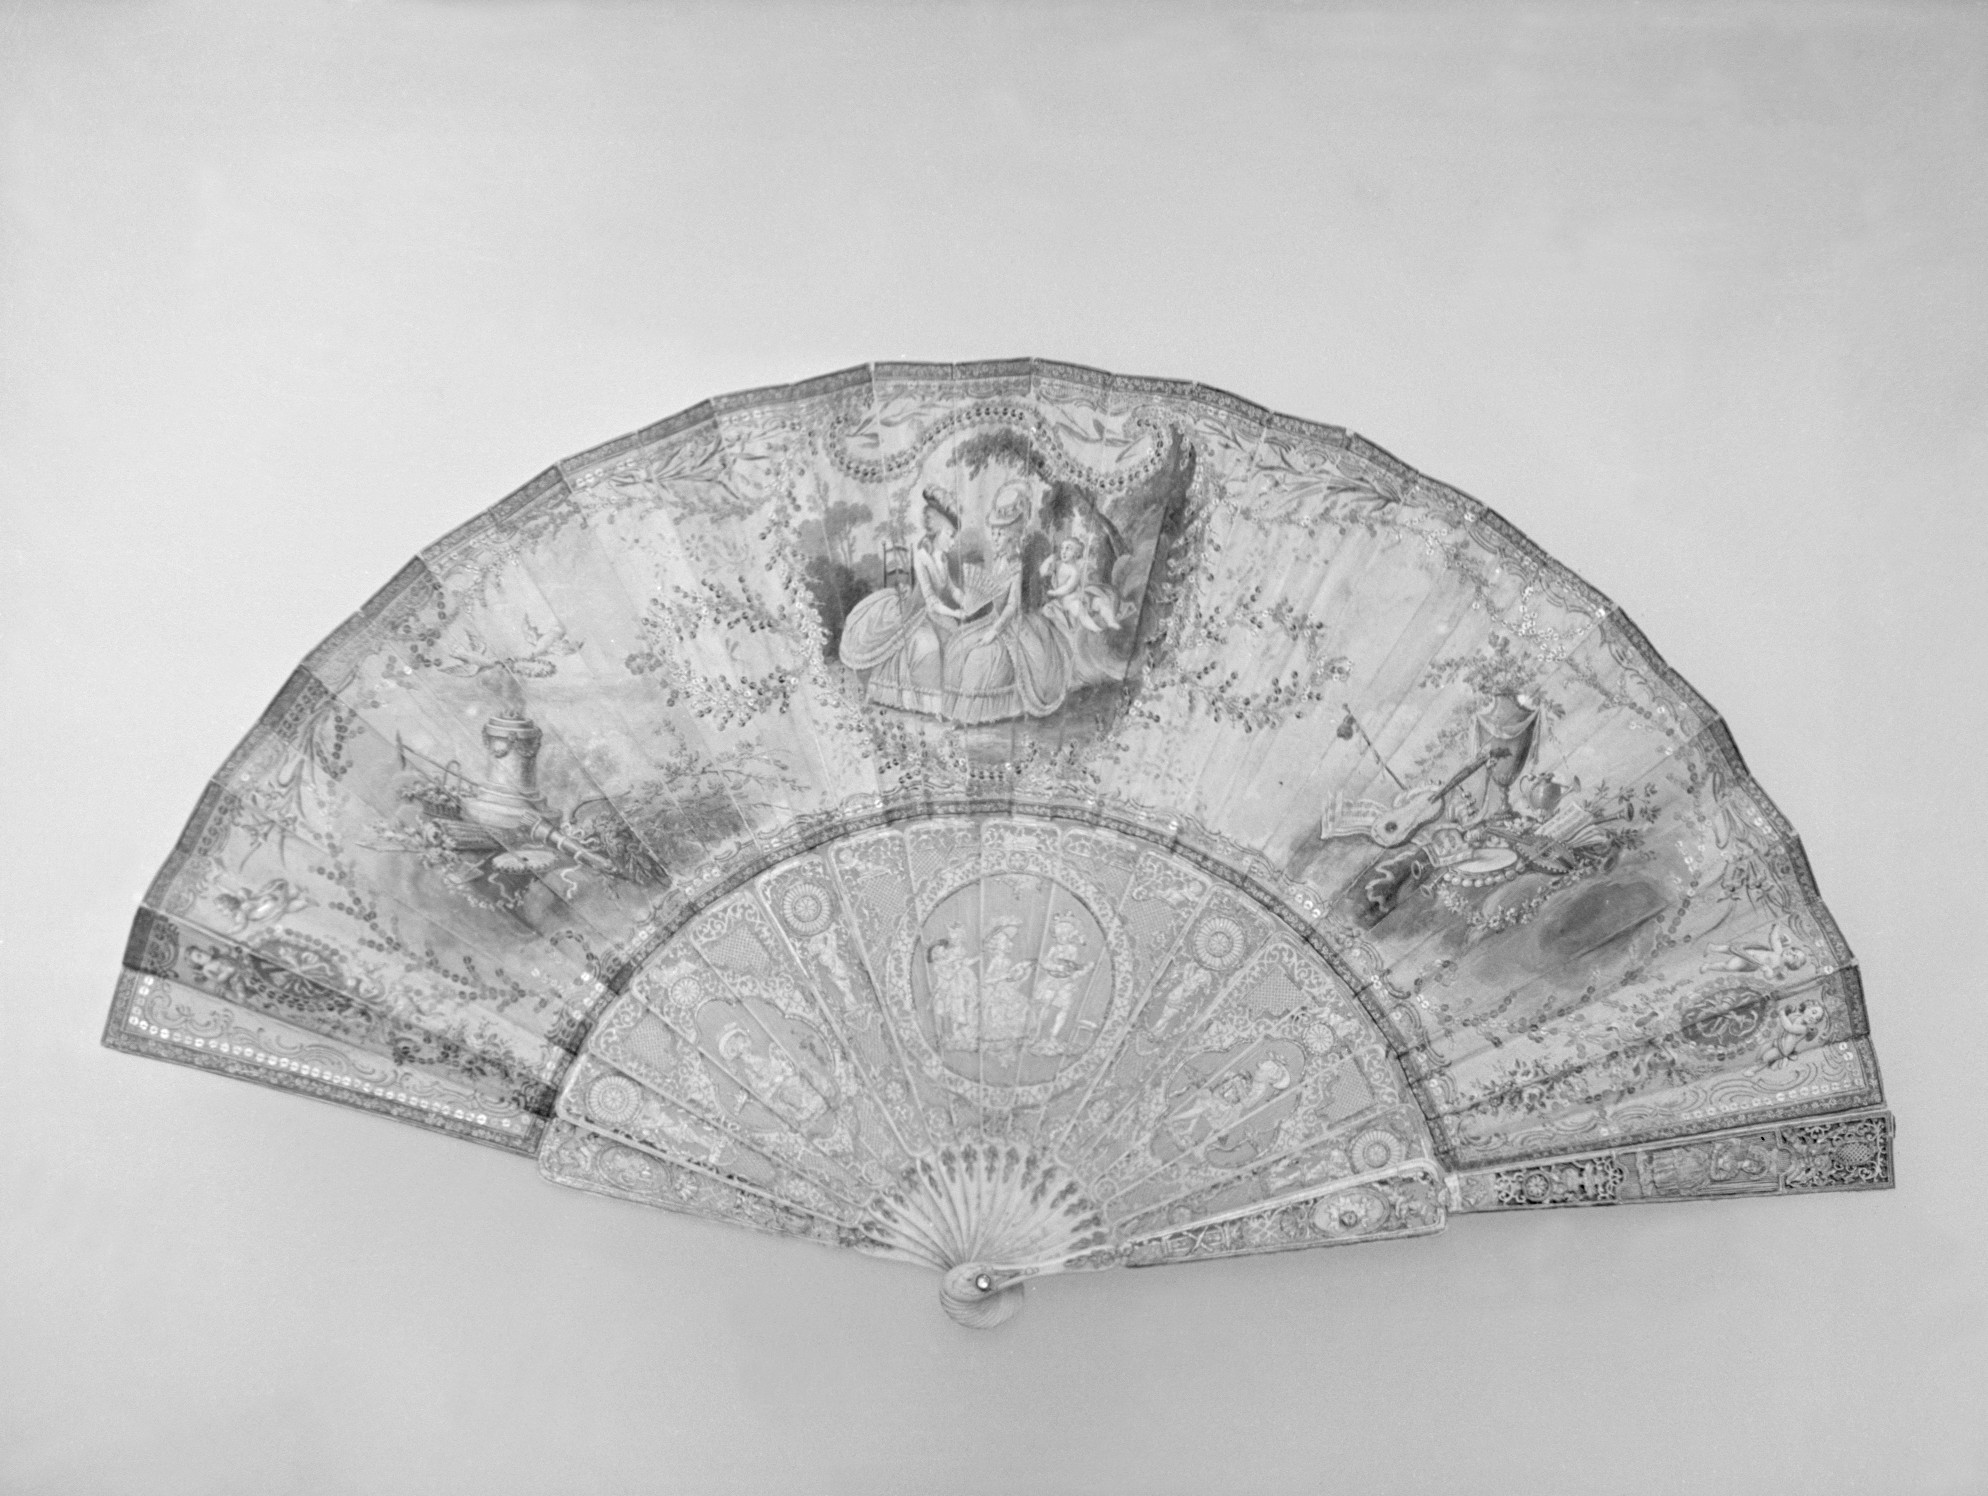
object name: fan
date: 1776-1800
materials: gold, ivory, paper, silk, silver gilt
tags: musical instruments,birds,women